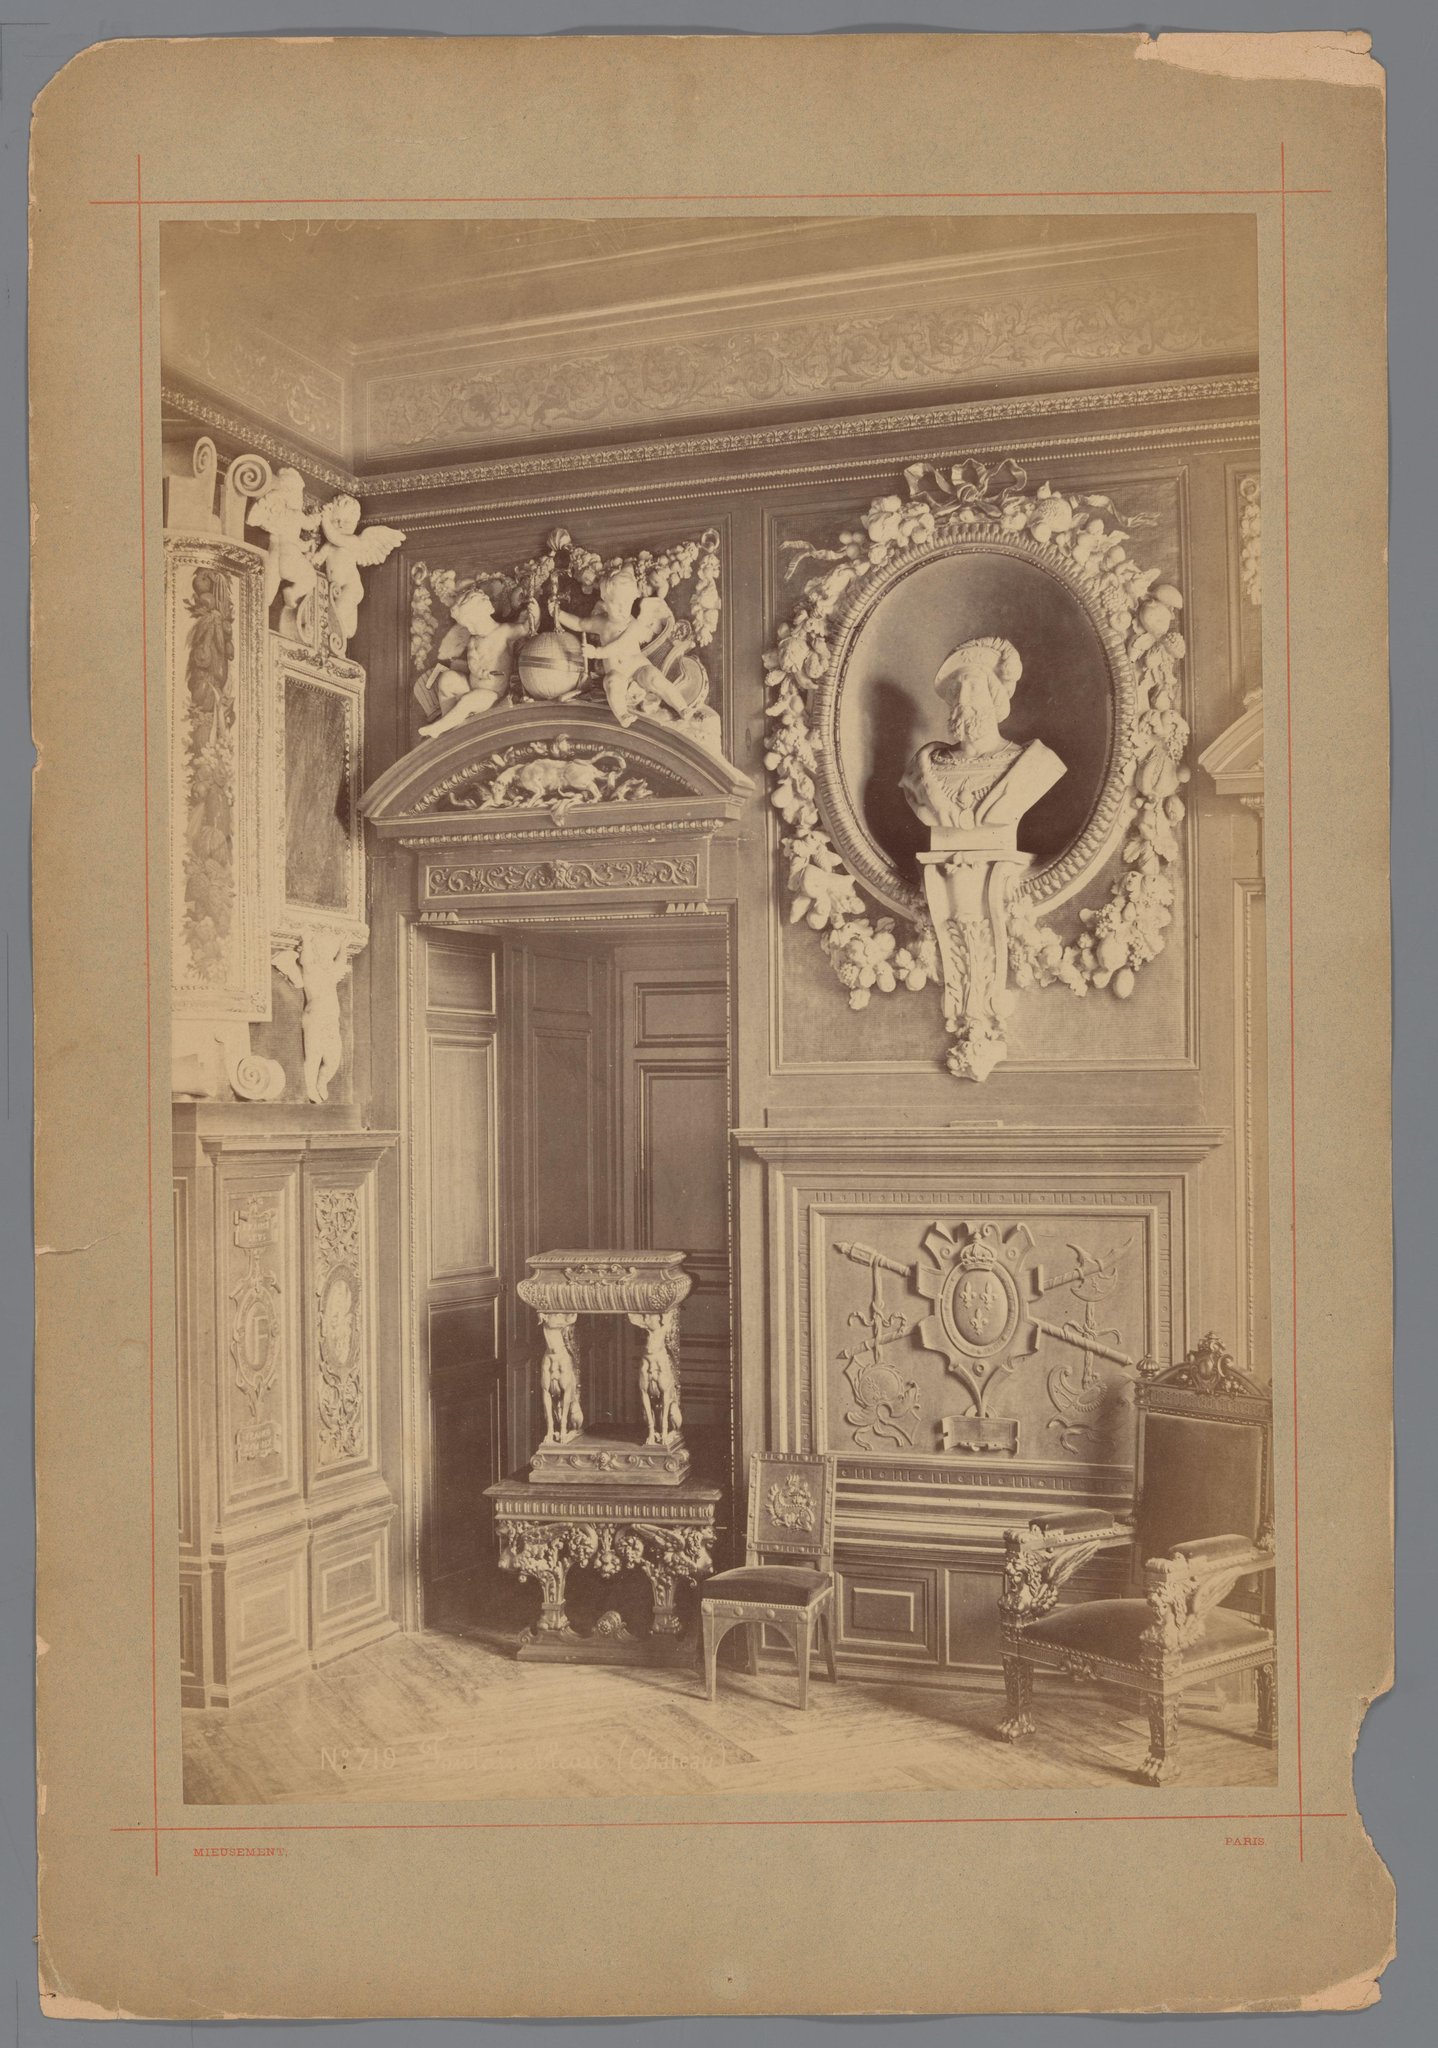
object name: photograph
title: Fontainebleau (Château)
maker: séraphin-médéric mieusement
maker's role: fotograaf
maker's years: 1840-1905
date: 1875-1900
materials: cardboard, photographic support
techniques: albumen print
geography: fontainebleau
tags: art collection, art gallery, palace, interior ~ representation of a building, historical persons (+ (full) bust portrait)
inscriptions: number: ‘No. 719’, name: ‘Monsters worden door de Representant J. A. G. de LEUR-den haag op franco aanvrage verzonden’, collector's mark: Lugt 3937, name: ‘MIEUSEMENT, PARIS’, inscription: ‘MONUMENTS HISTORIQUES’